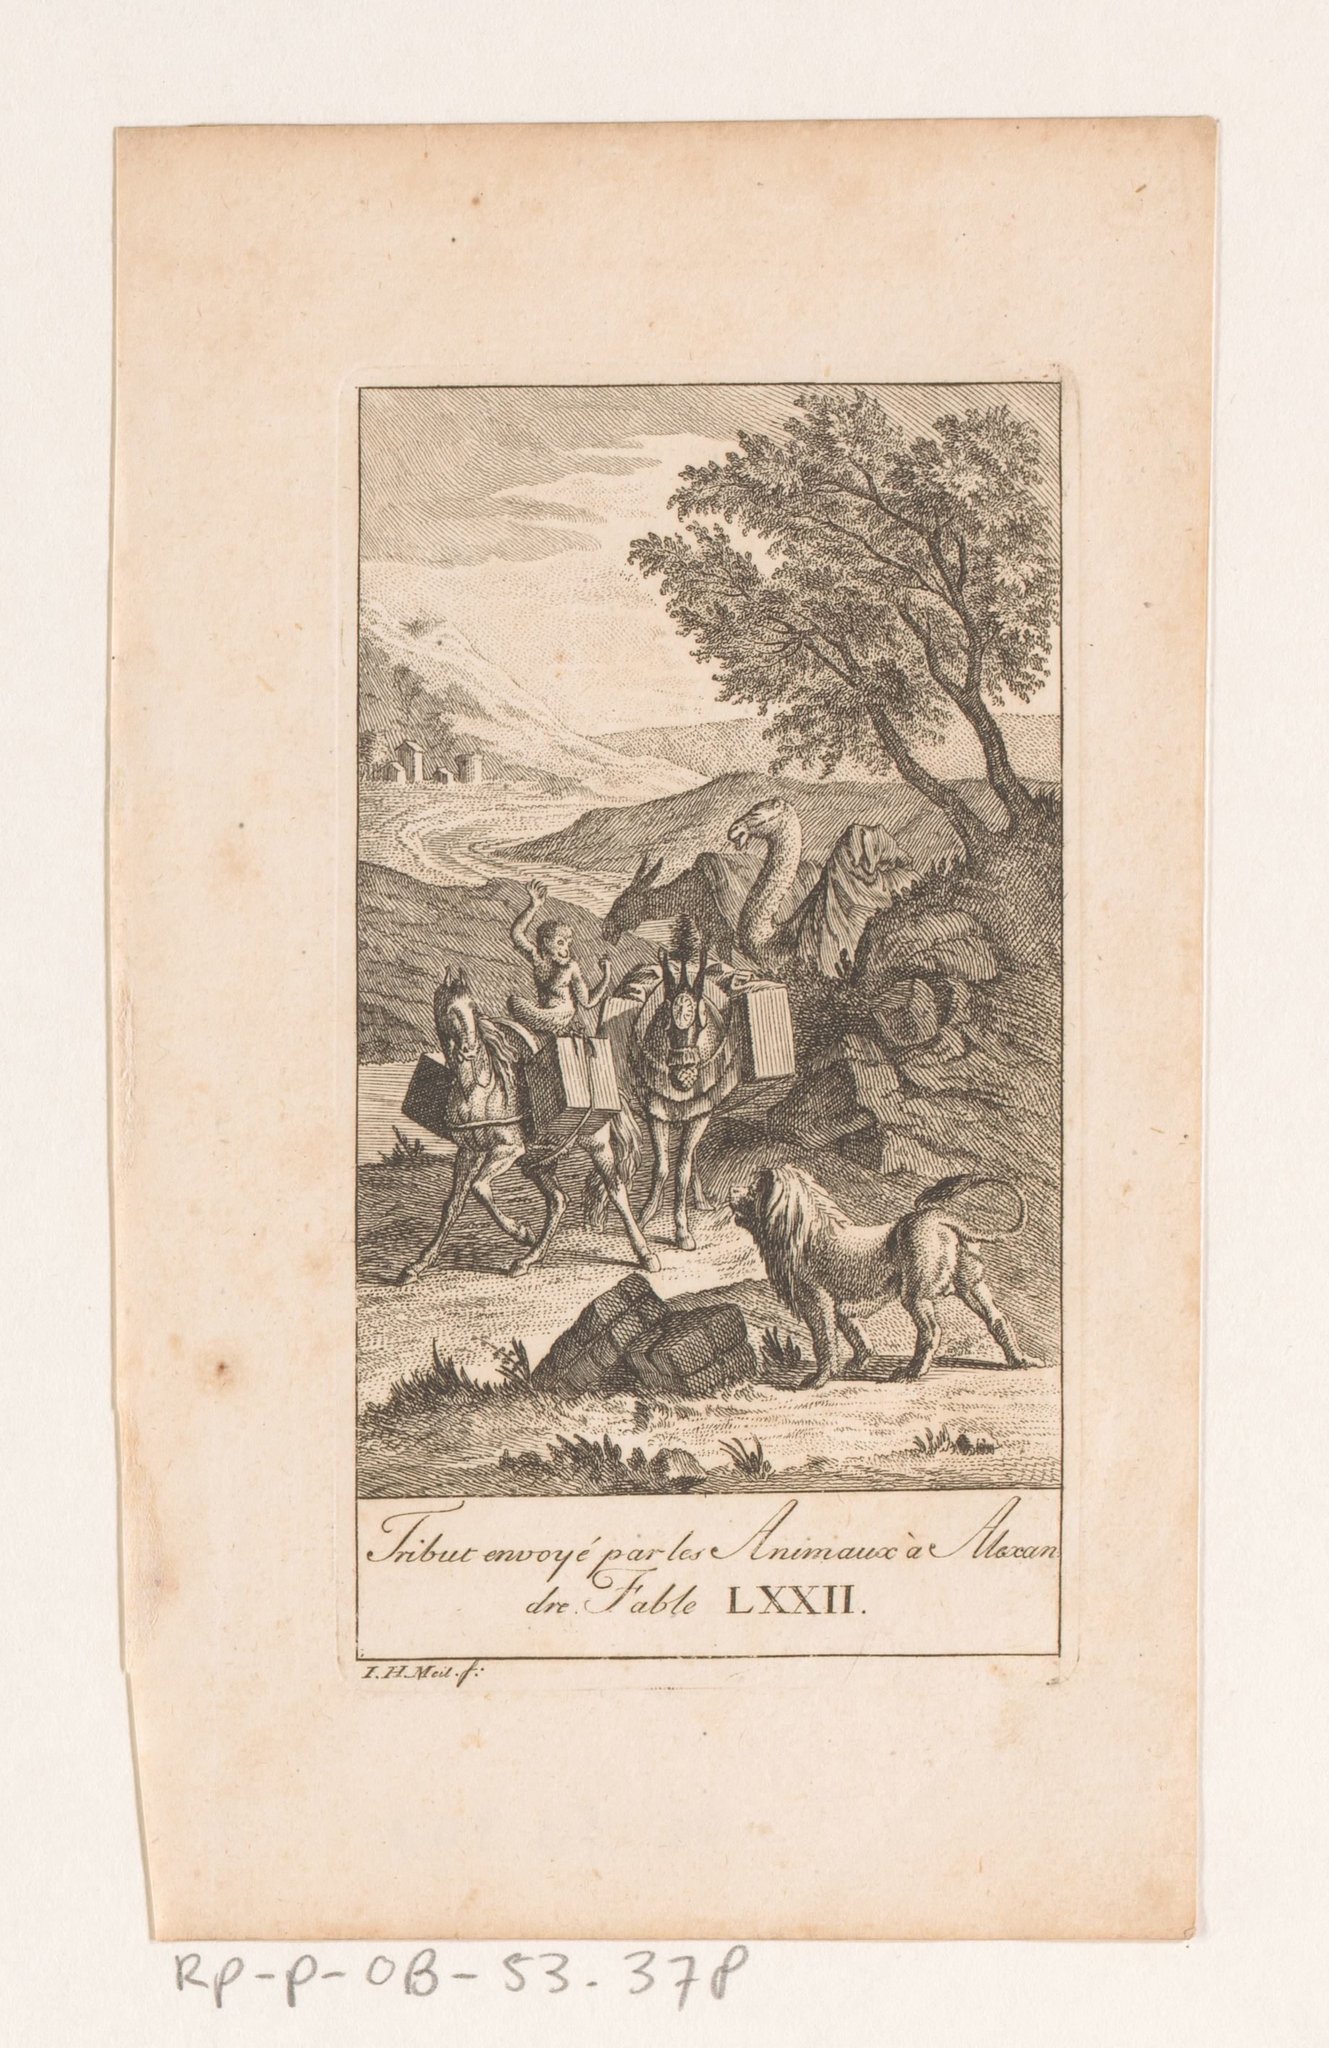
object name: book illustration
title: Tribut envoyé par les animaux à Alexandre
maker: johann heinrich meil (der ältere)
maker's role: print maker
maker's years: 1730-1820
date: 1758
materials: paper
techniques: etching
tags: fables of lafontaine : use 85(...), riding a horse, ass, or mule; rider, horseman, animals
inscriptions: collector's mark: Lugt 2228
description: Illustratie uit: Fontaine, J. de la. Fables choisies, mises en vers. Dl. 2. Dresden & Leipzig: George Conrad Walther, 1758.